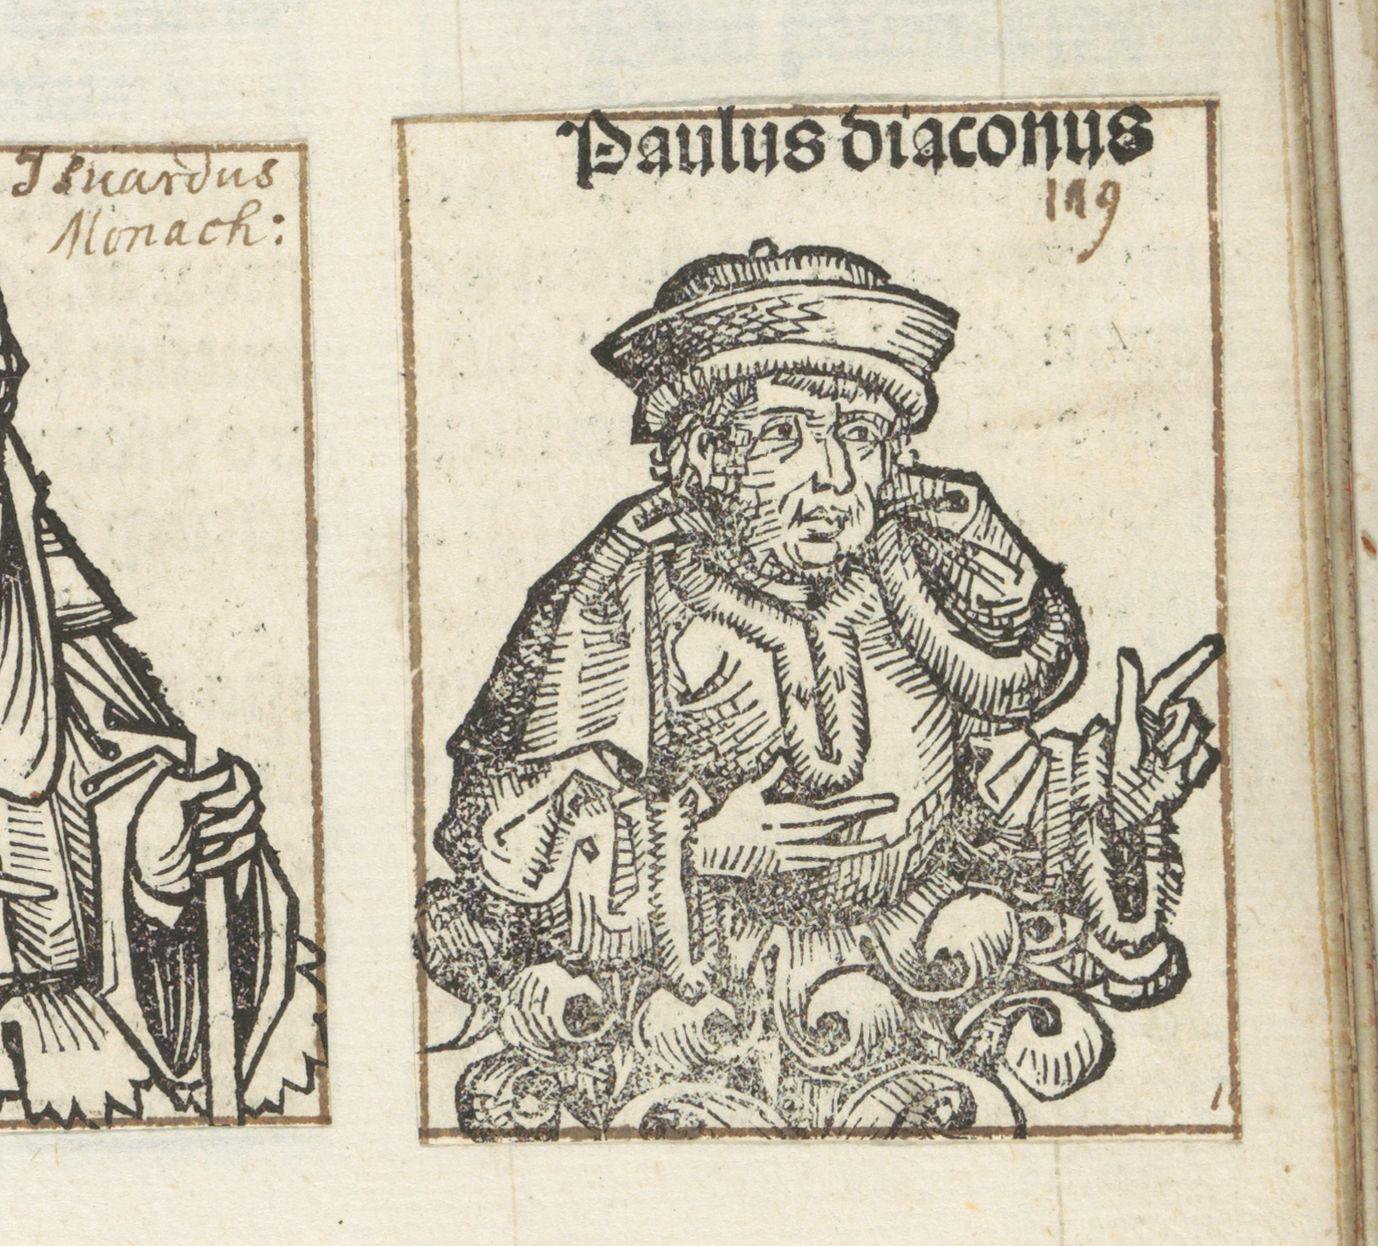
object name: album leaf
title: Liber Chronicarum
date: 1493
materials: paper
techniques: letterpress printing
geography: nuremberg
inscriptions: inscription: ‘149’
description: De houtsnede wordt herhaaldelijk gebruikt als boekillustratie in de Liber Chronicarum (of Neurenbergkroniek) van Hartmann Schedel, verschenen in het Latijn en Duits in 1493. Zie de Latijnse uitgave, folio 166v.